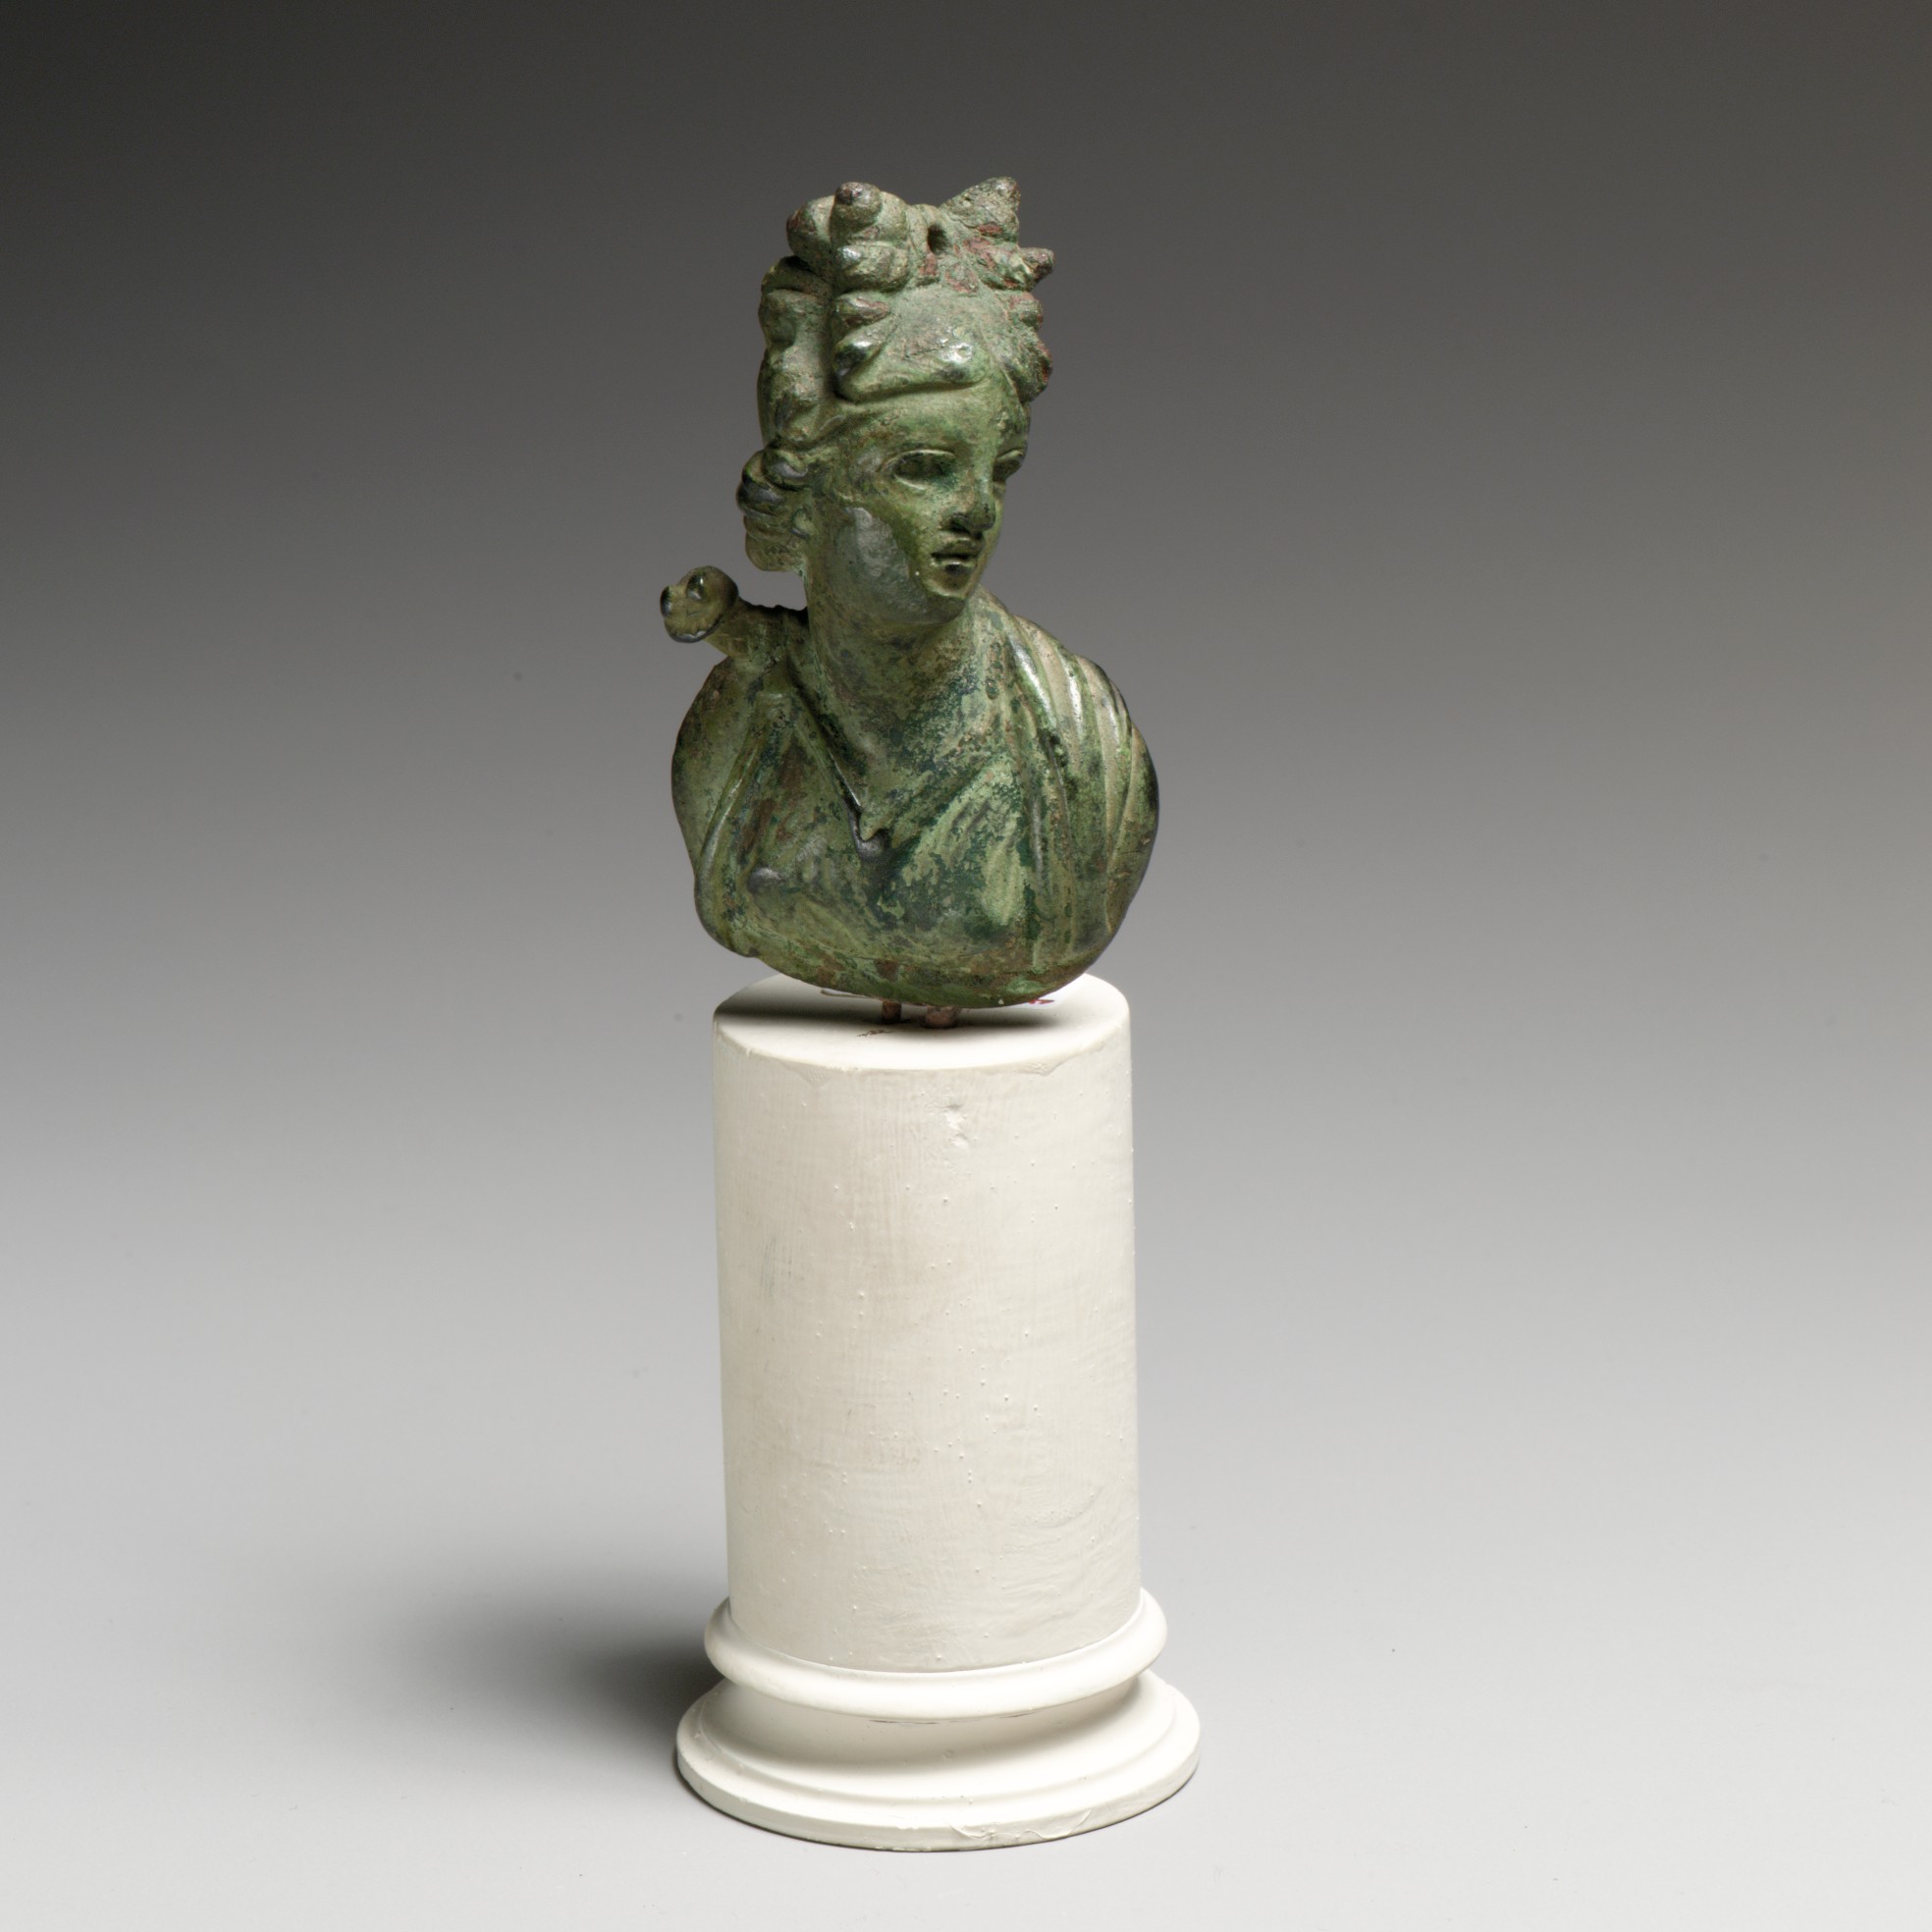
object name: bust of artemis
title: Bronze bust of Artemis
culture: roman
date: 1-50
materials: bronze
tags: portraits,women,artemis